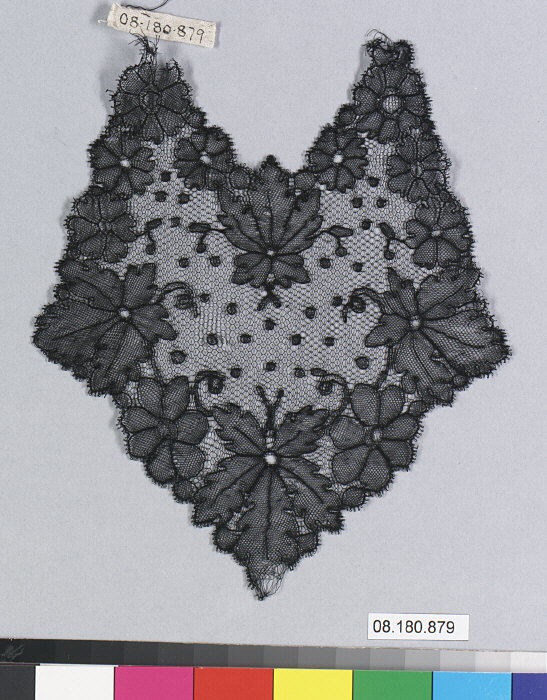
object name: tie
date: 1801-1900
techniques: lace